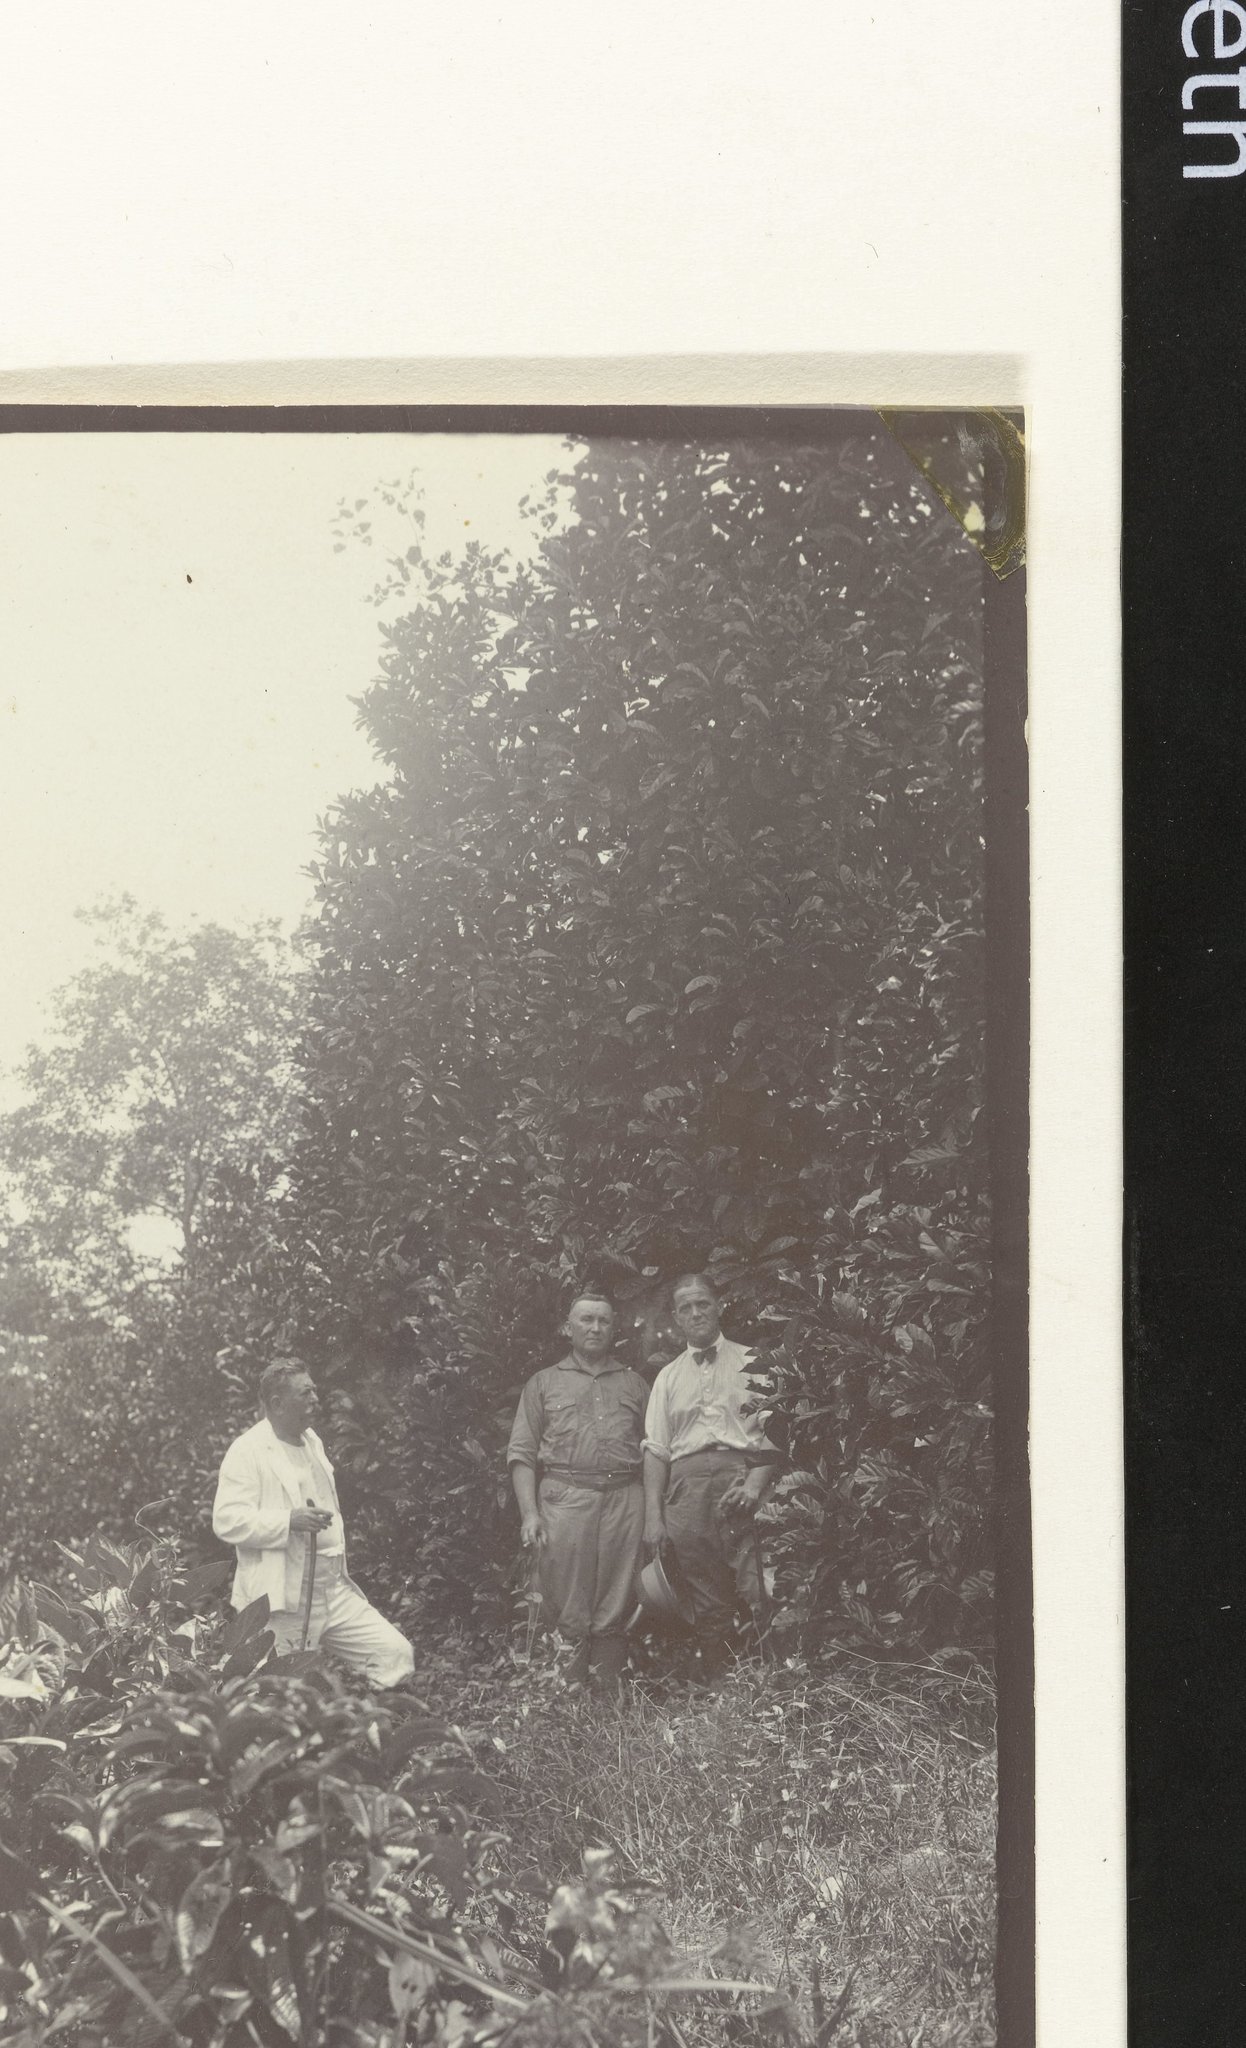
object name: photograph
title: Drie mannen op plantage Accaribo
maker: Anonymous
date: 1911-1932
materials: photographic support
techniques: photography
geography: suriname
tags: amsterdam, theodoor brouwers, suriname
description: In de periode 1911-1932 woonde op plantage Accaribo in Suriname de familie Brouwers van wie de foto's afkomstig zijn. Rond 1910 vond Theodoor Brouwers werk op plantage Accaribo. In 1929 werd hij eigenaar van de plantage.